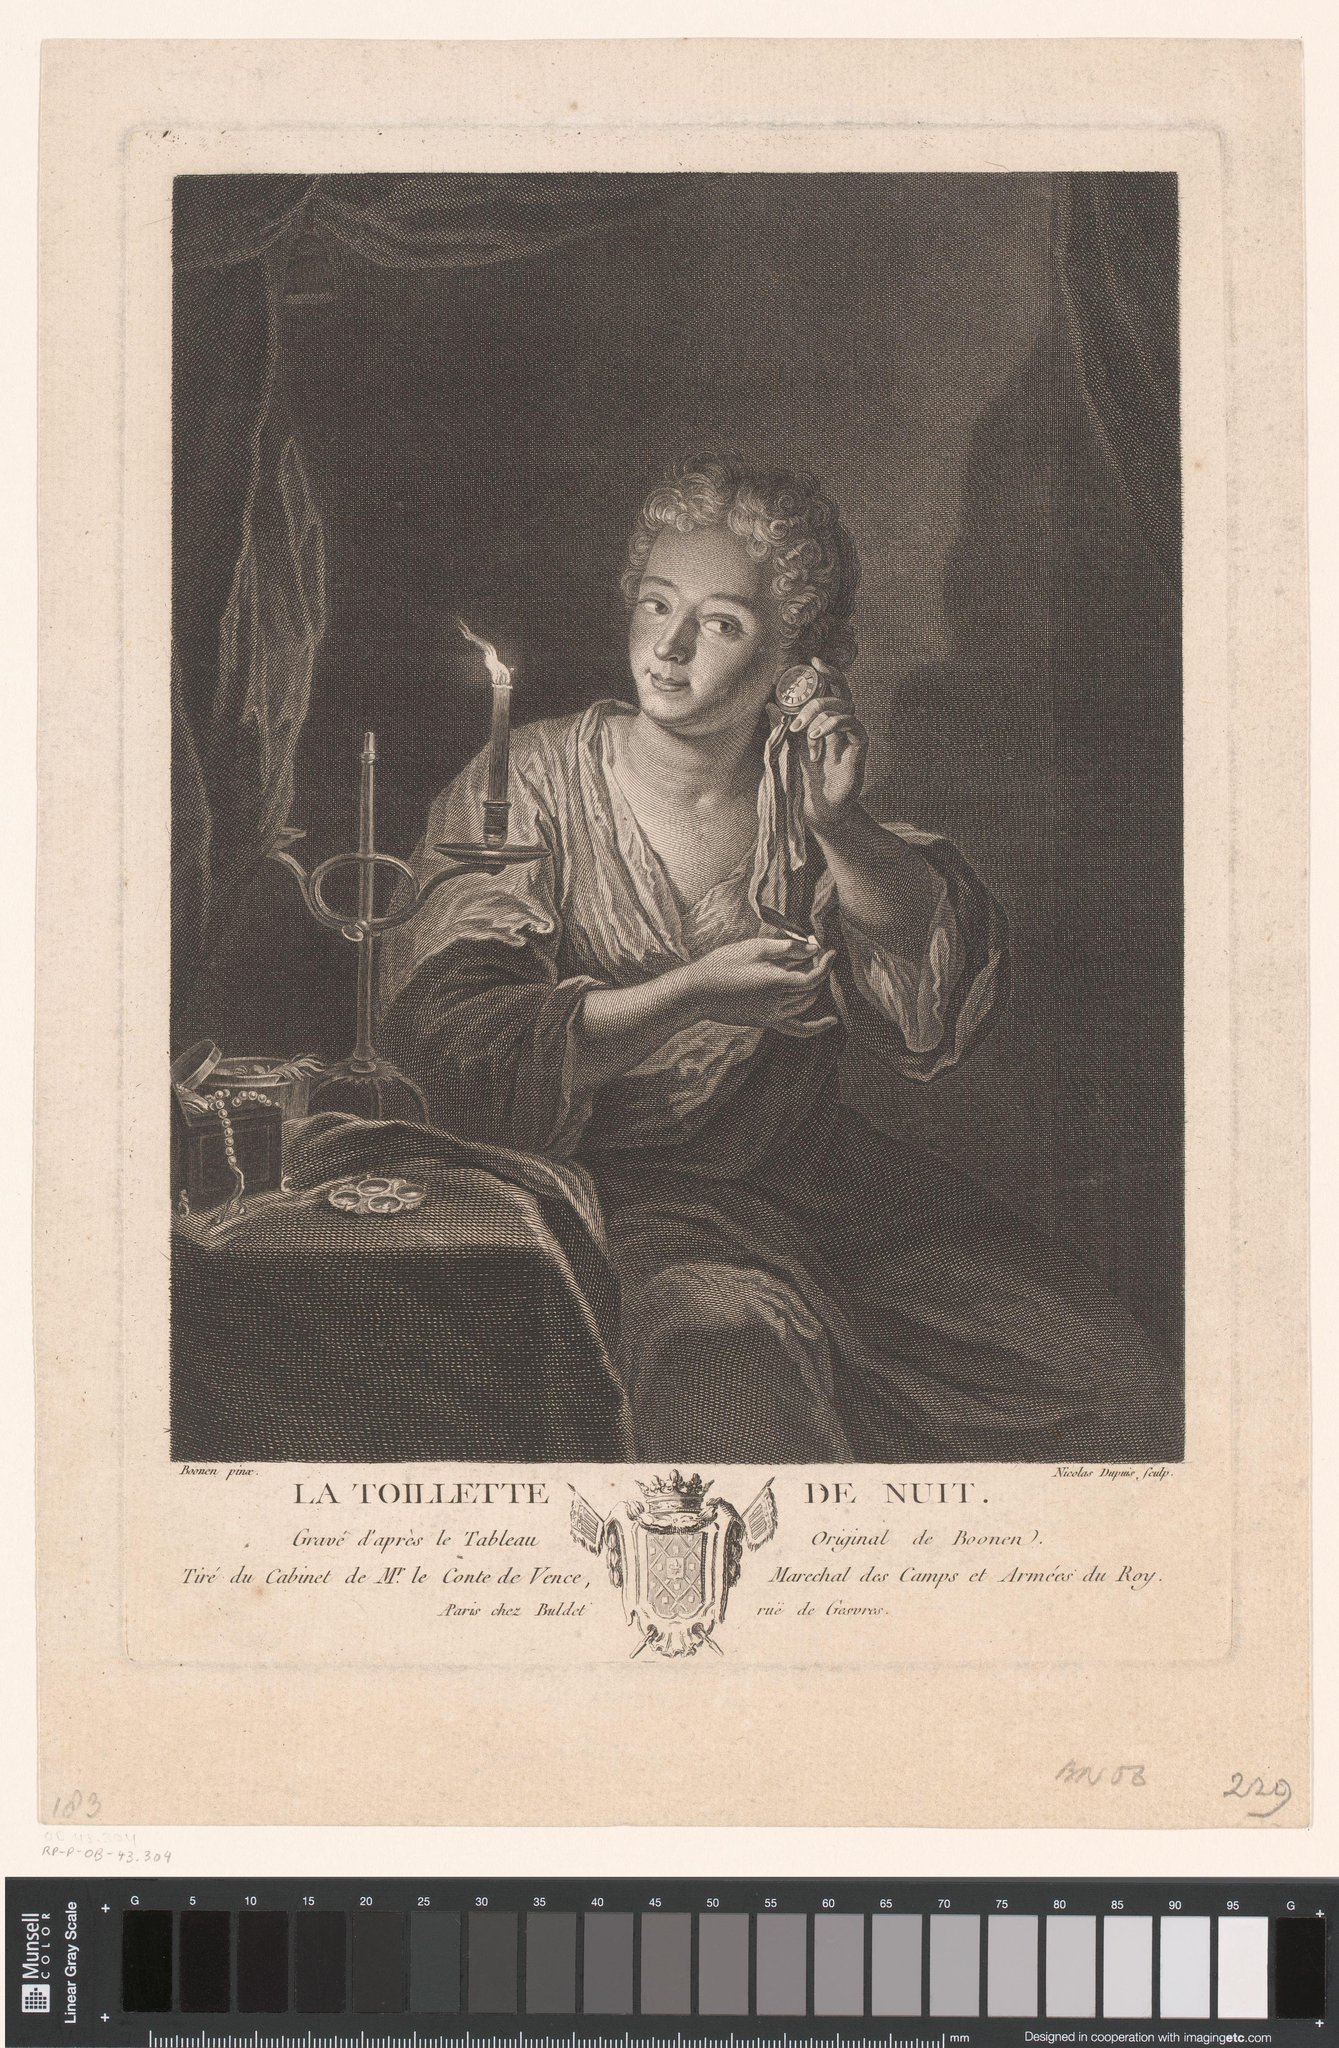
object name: print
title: La toilette de nuit.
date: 1759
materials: paper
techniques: engraving, etching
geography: france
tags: making toilet - aa - (for) women, watch, night, armorial bearing, heraldry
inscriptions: collector's mark: Lugt 2228